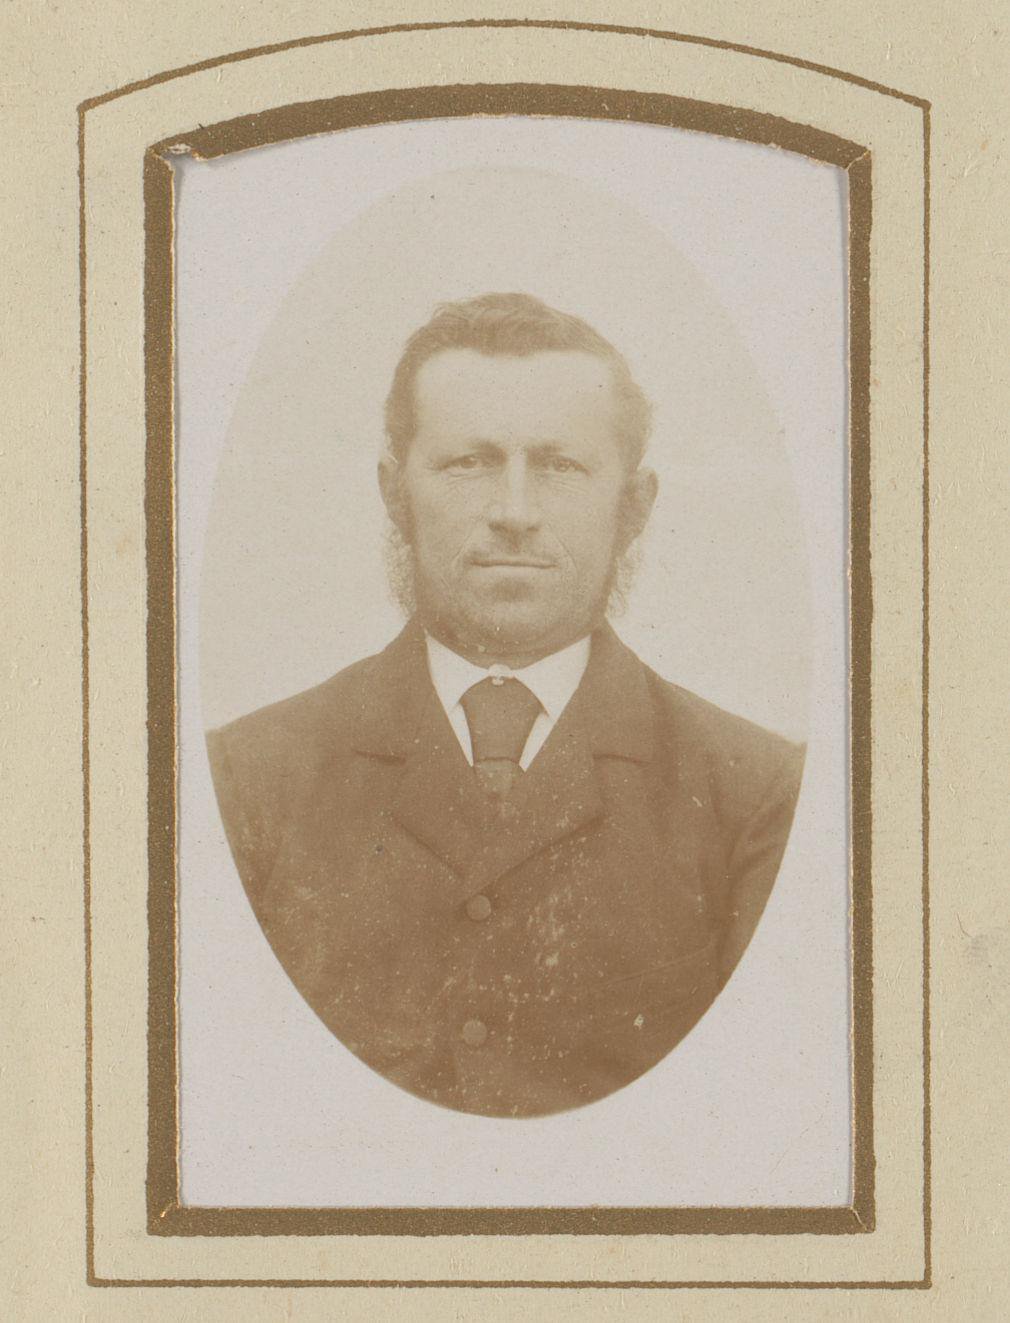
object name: album leaf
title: Portret van een man met bakkebaarden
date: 1890-1910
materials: cardboard, photographic support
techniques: collodion silver print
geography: amsterdam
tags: sideburns, historical persons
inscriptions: inscription: ‘D. Fraenkel & Zoon/ PHOTOGRAPHEN/ Amsterdam 43.Commelinstraat 43./ Specialiteit in vergrootingen van deze Portretten/ kunnen steeds nabesteld worden.’